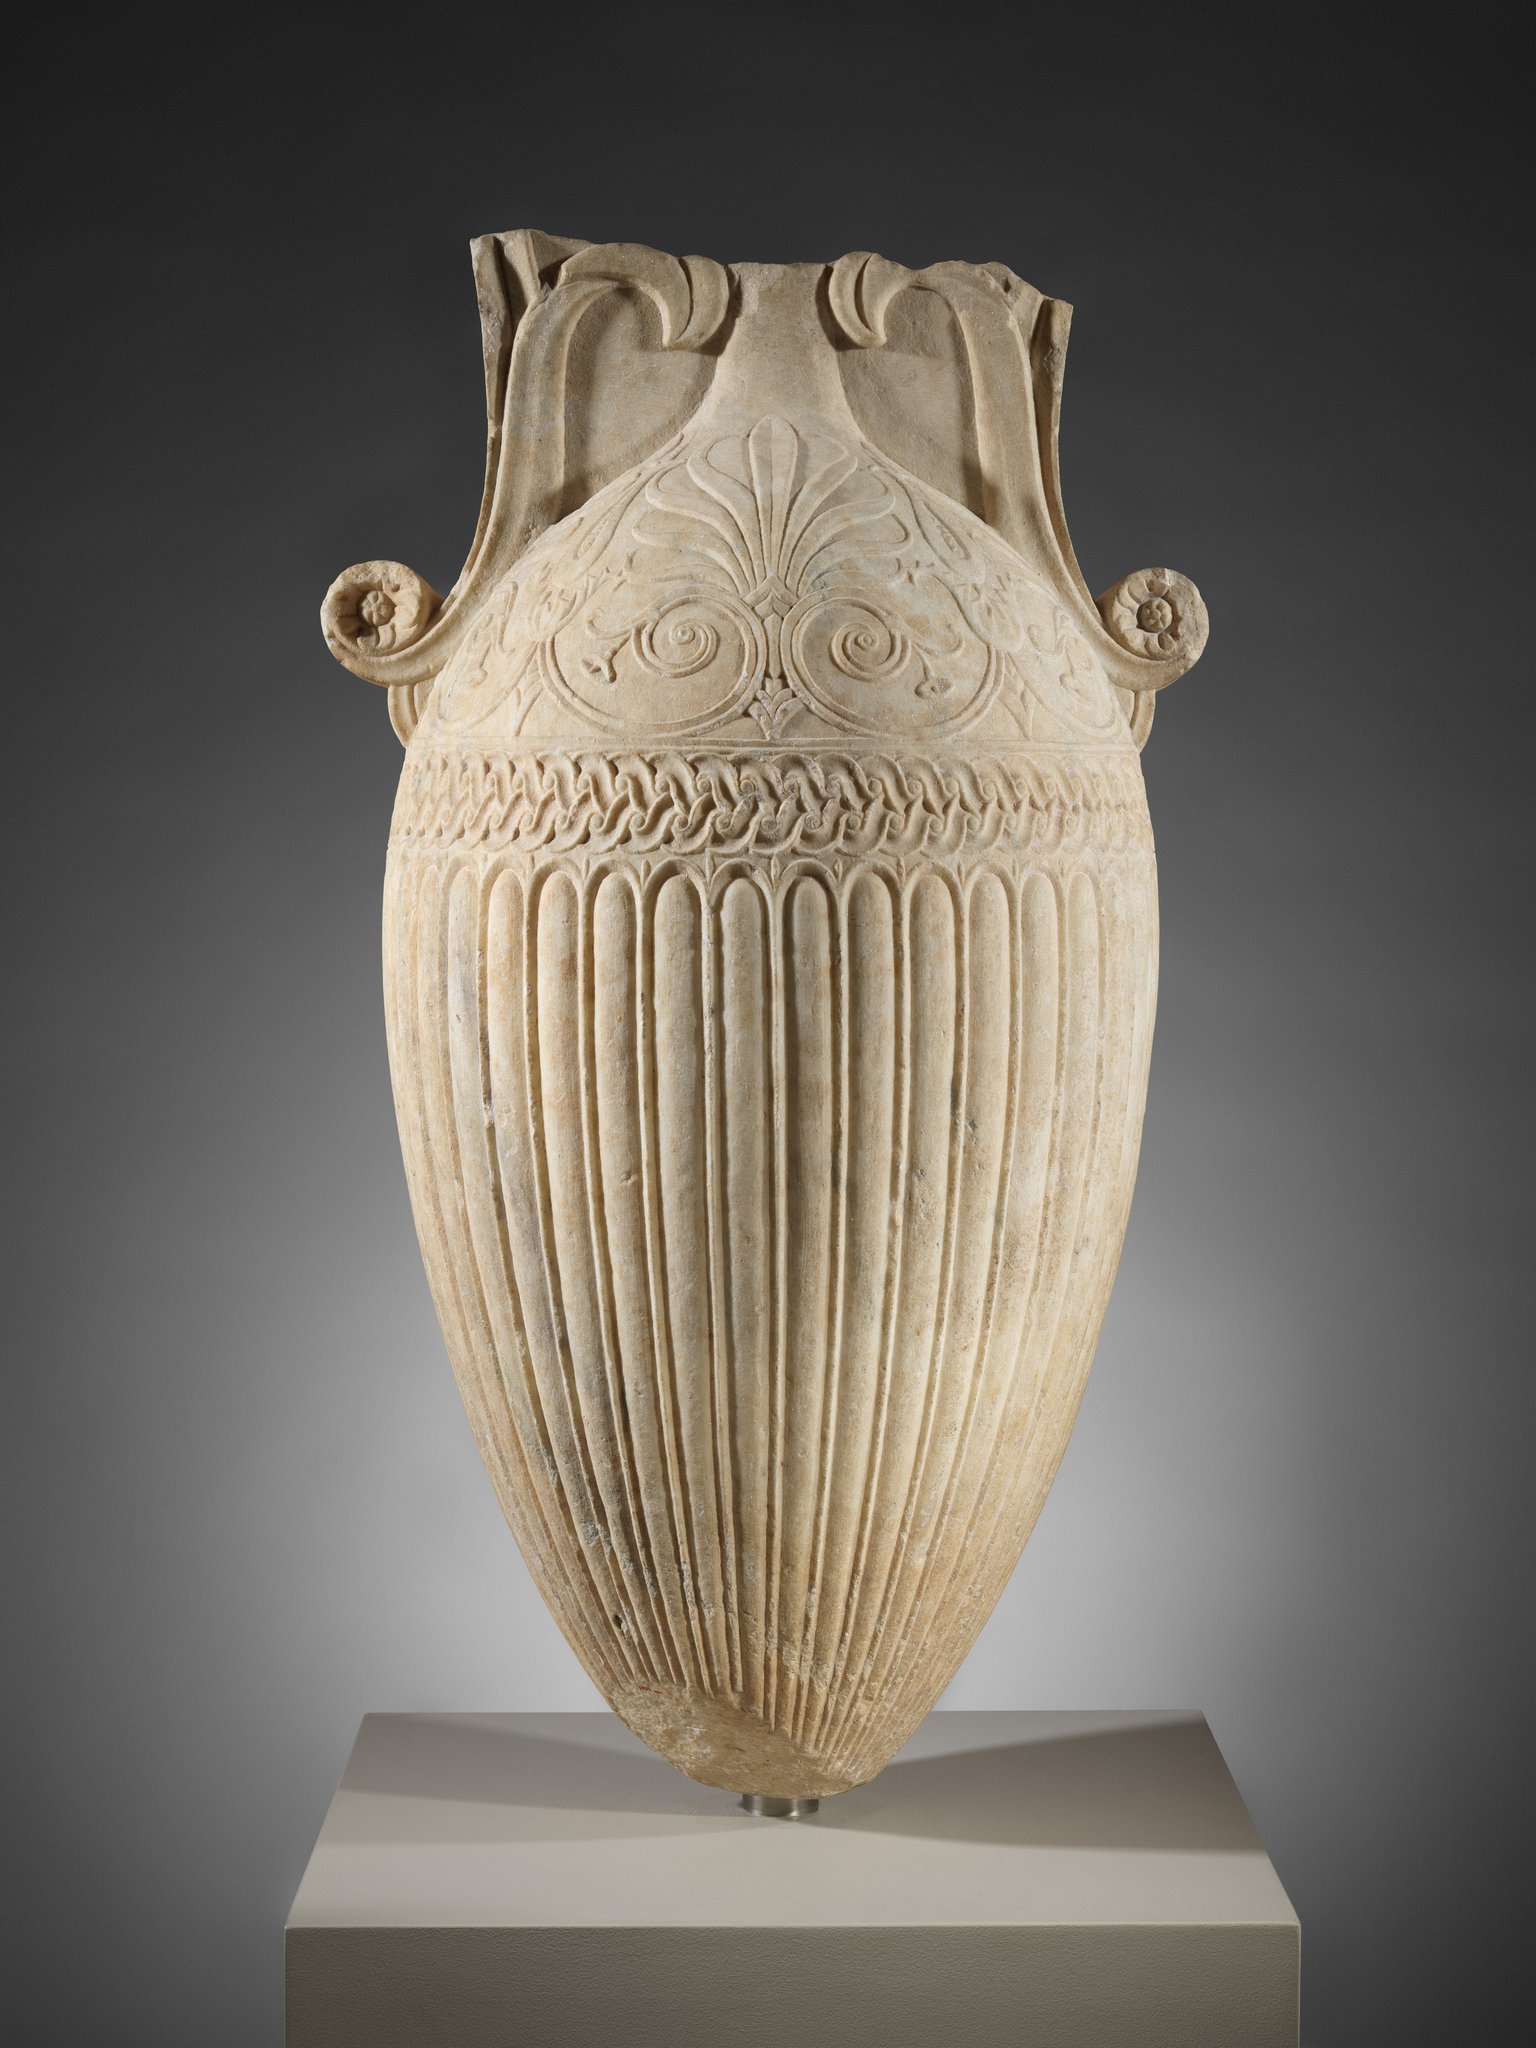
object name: loutrophoros, funerary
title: Marble funerary loutrophoros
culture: greek, attic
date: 400-301 BCE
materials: marble